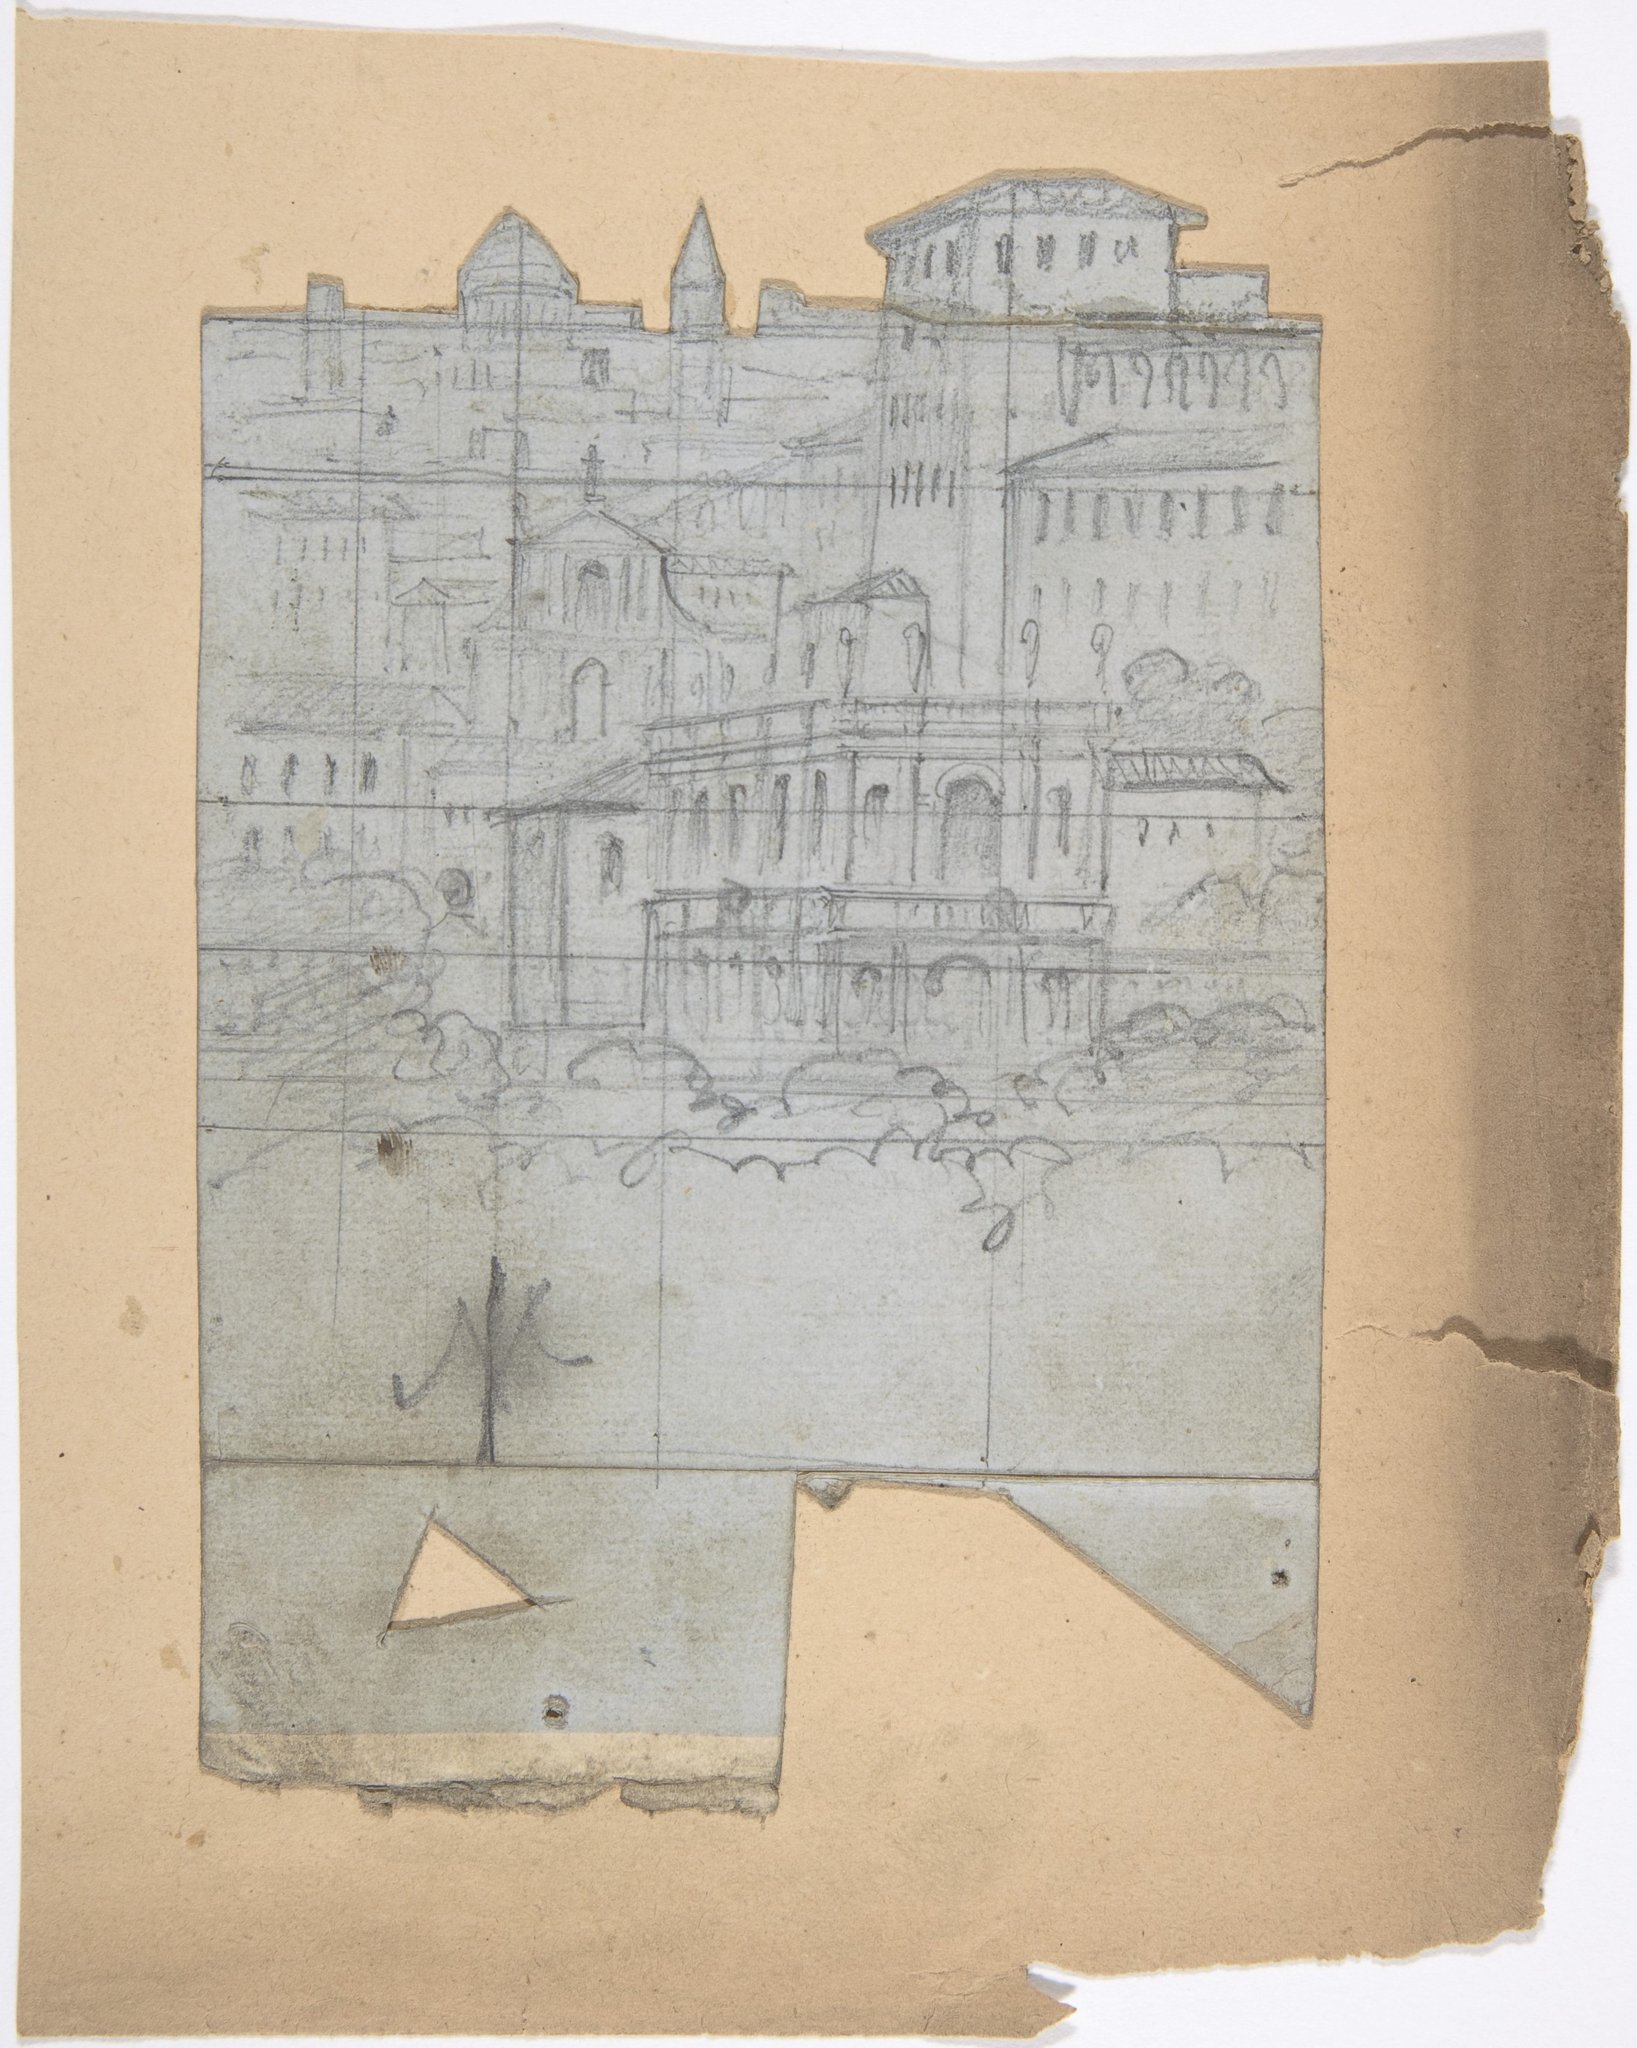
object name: drawing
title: Design for a Stage Set at the Opéra, Paris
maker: eugène cicéri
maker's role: artist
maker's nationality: french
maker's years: 1813-1890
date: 1830-1890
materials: graphite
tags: buildings,stage design